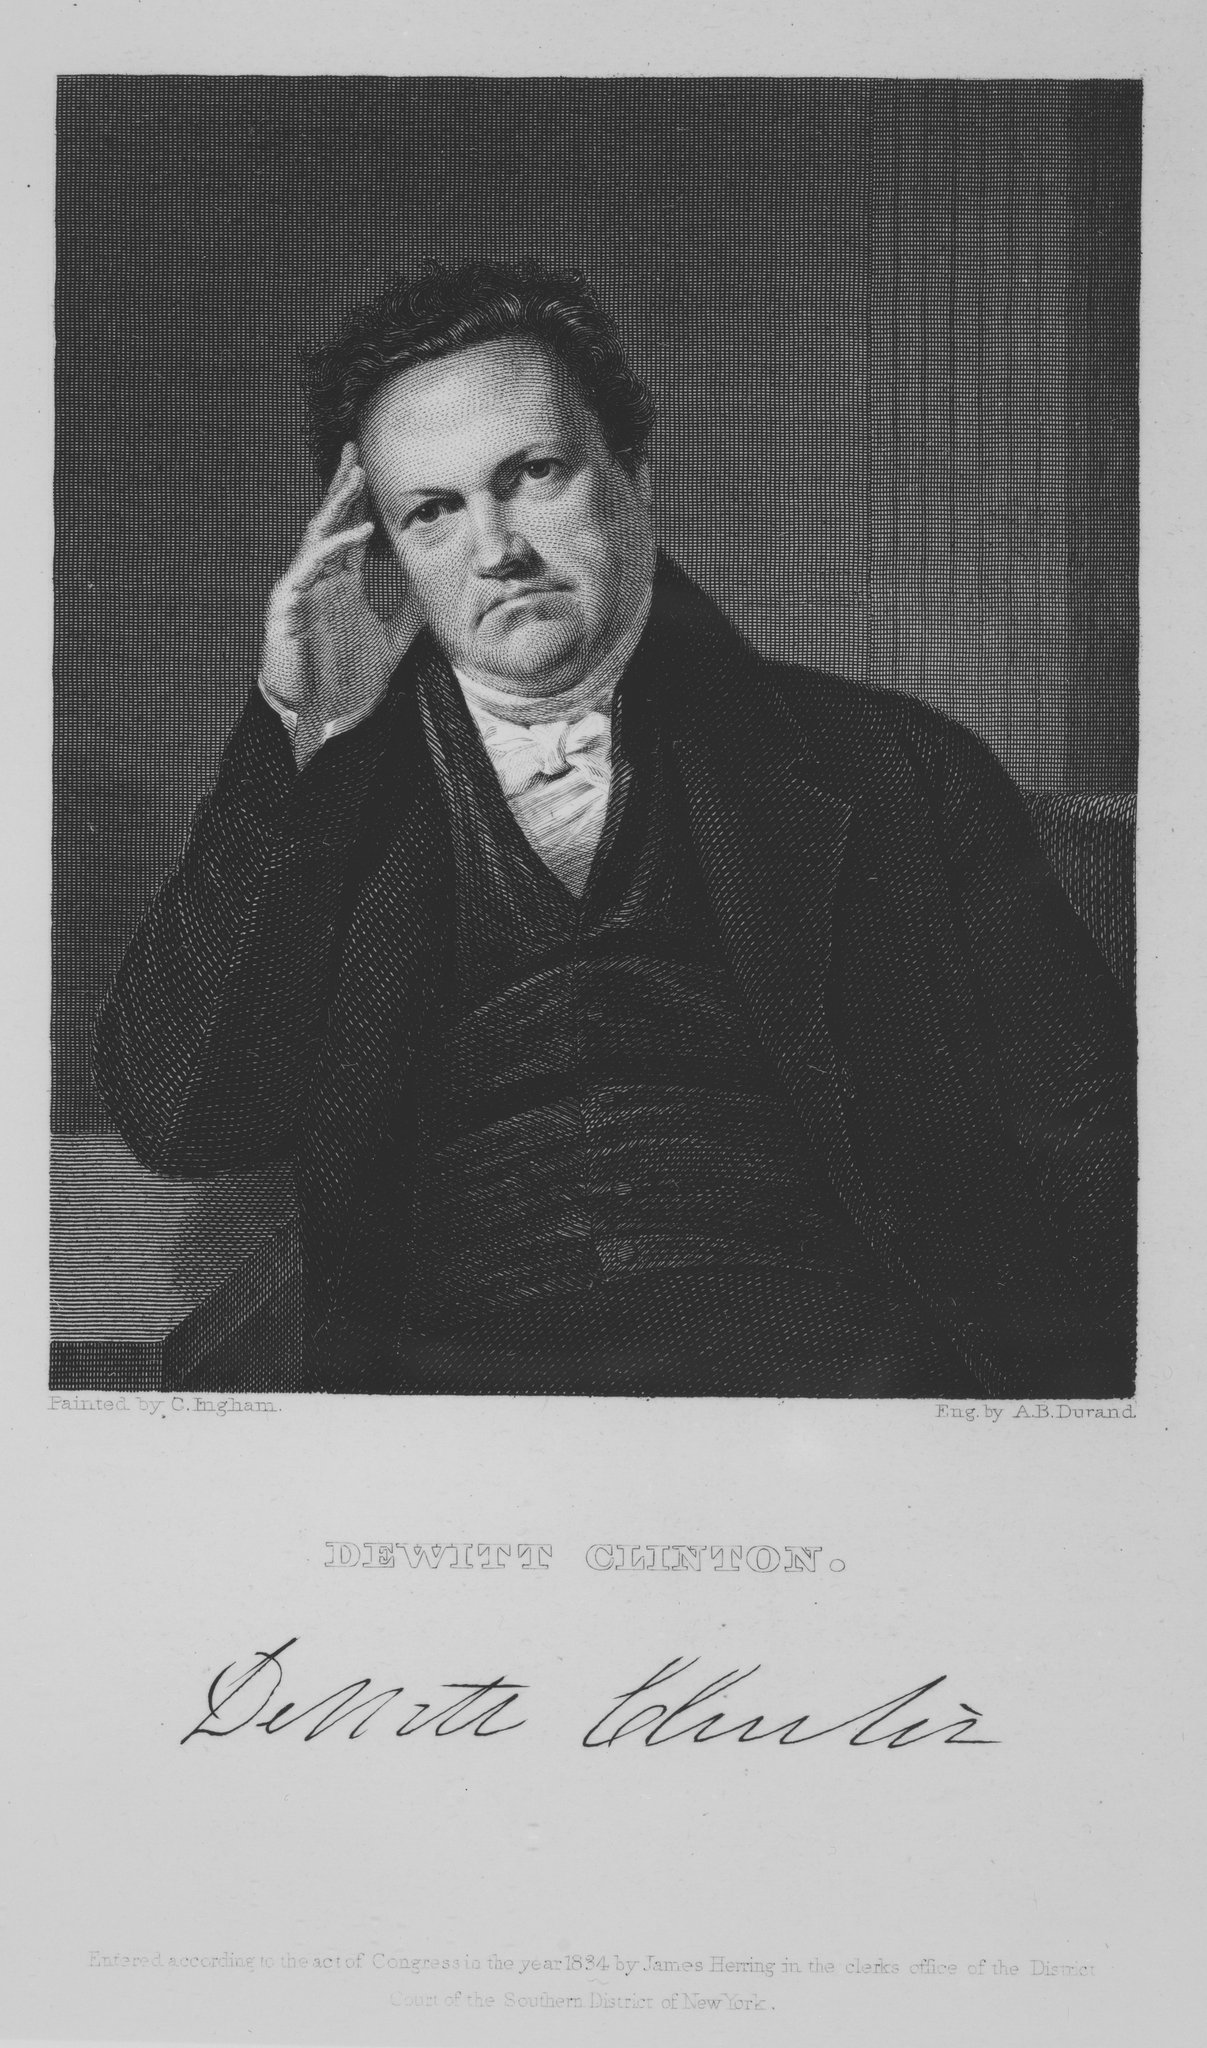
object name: book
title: The National Portrait Gallery of Distinguished Americans, Vol. II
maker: james barton longacre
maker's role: artist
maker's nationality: american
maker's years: 1794-1869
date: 1835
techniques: etching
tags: men,portraits